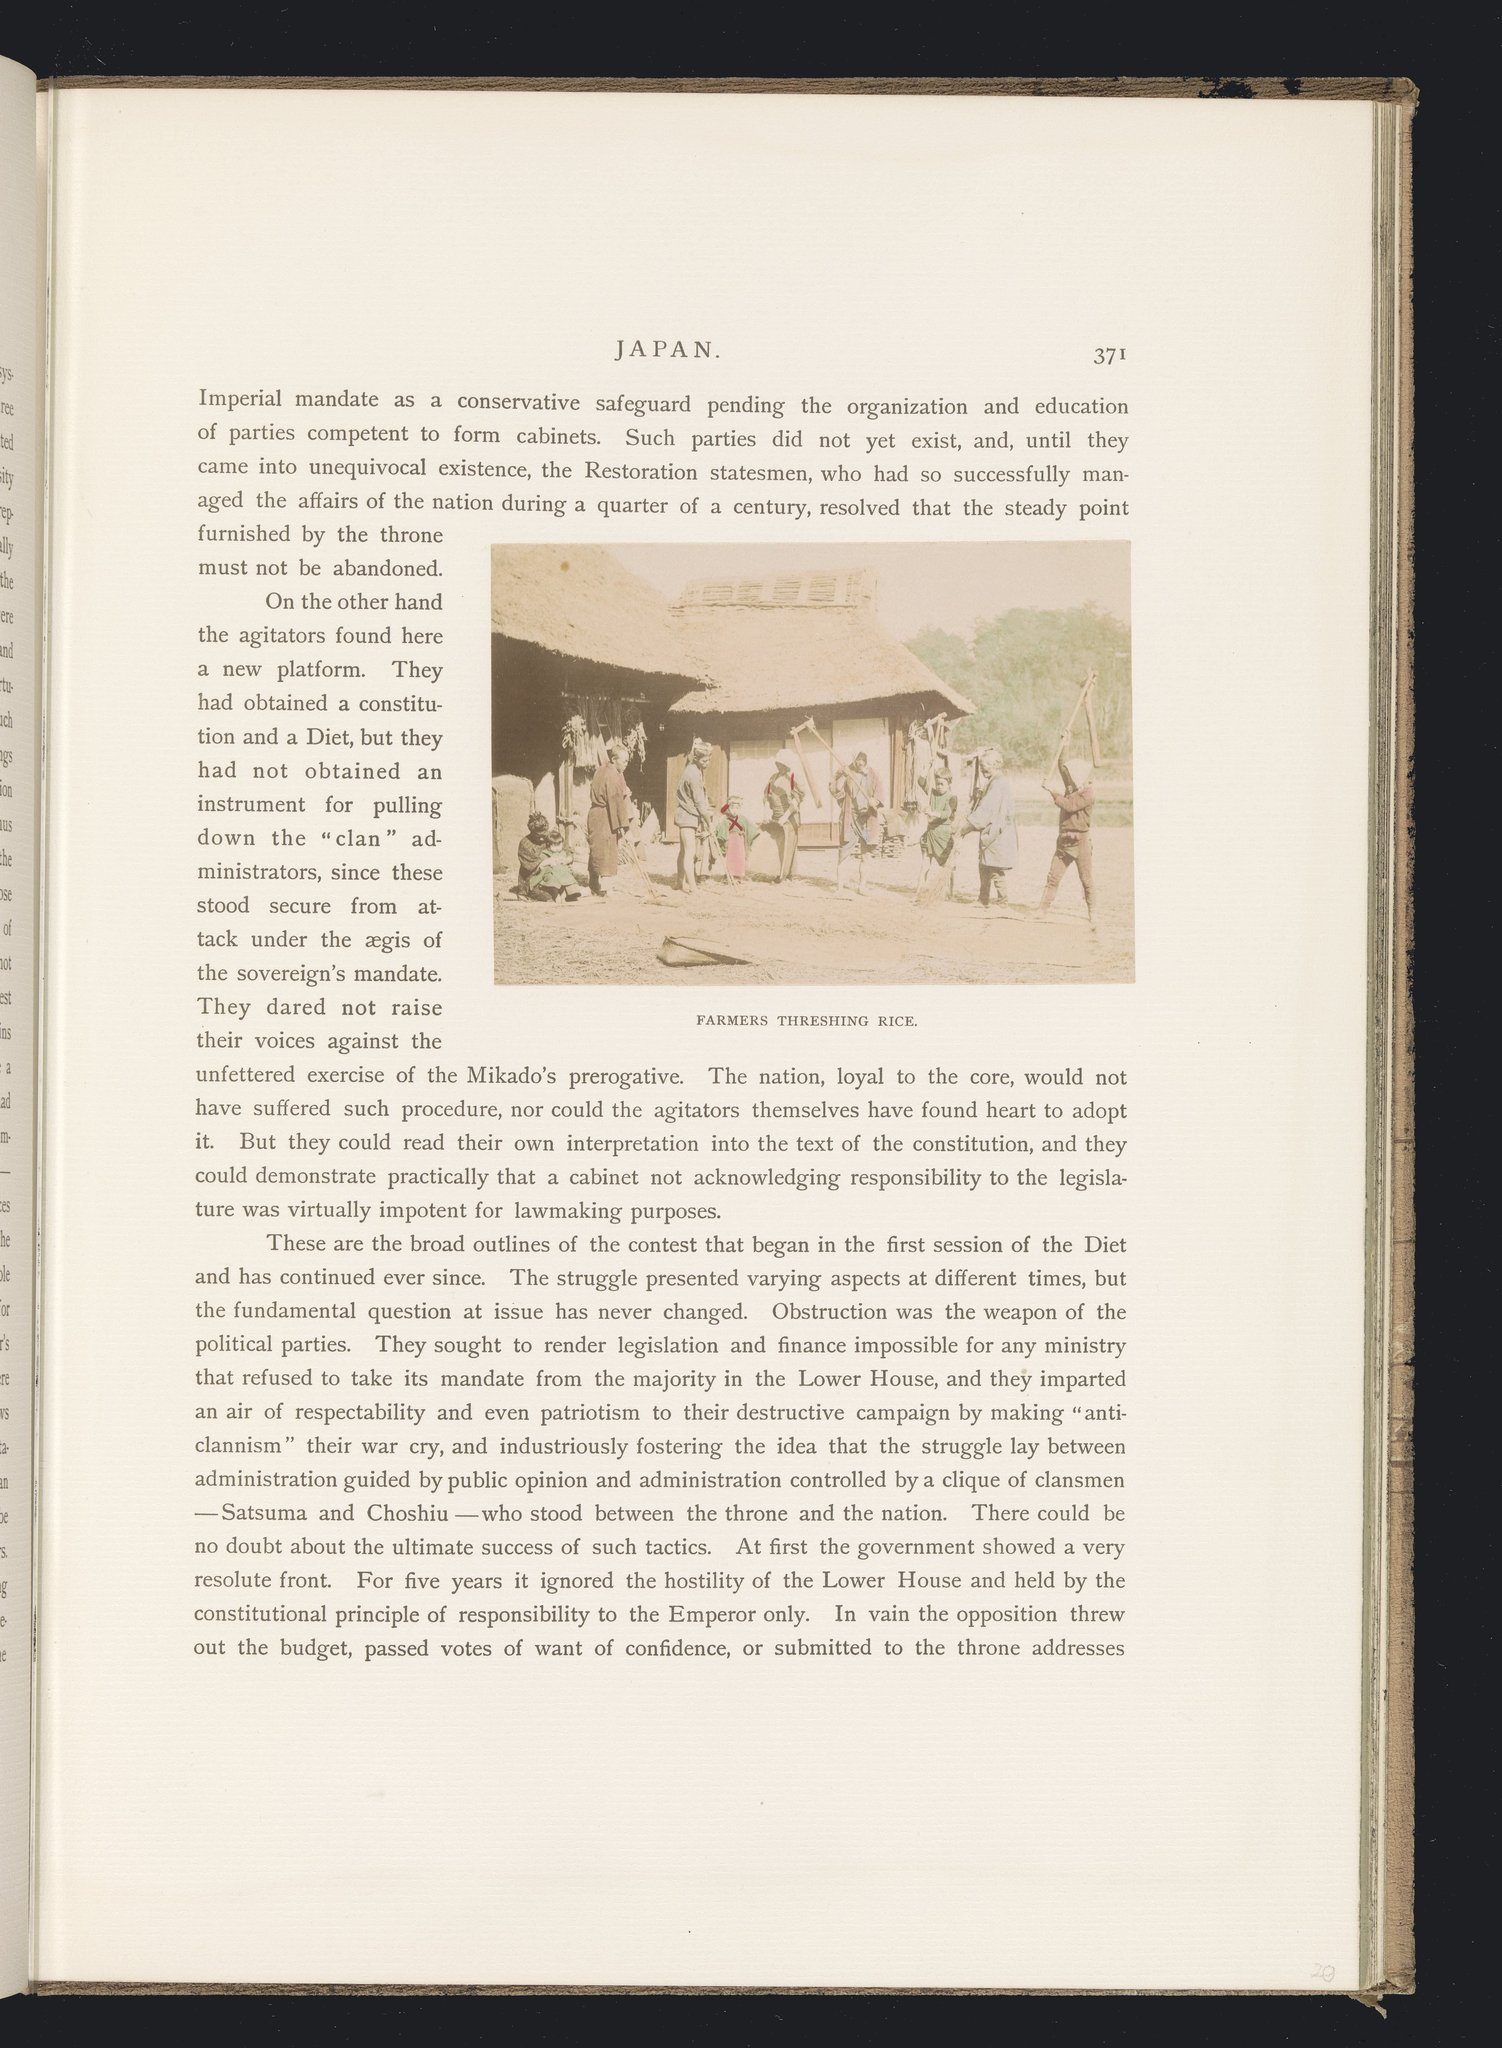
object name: page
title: Farmers threshing rice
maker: Anonymous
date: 1888-1898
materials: photographic support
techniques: albumen print, hand coloring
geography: japan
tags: farmers, cereal, grain, corn (grass with grains, grown for food, e.g.: wheat, rice, rye, oats, maize, buckwheat, millet), threshing